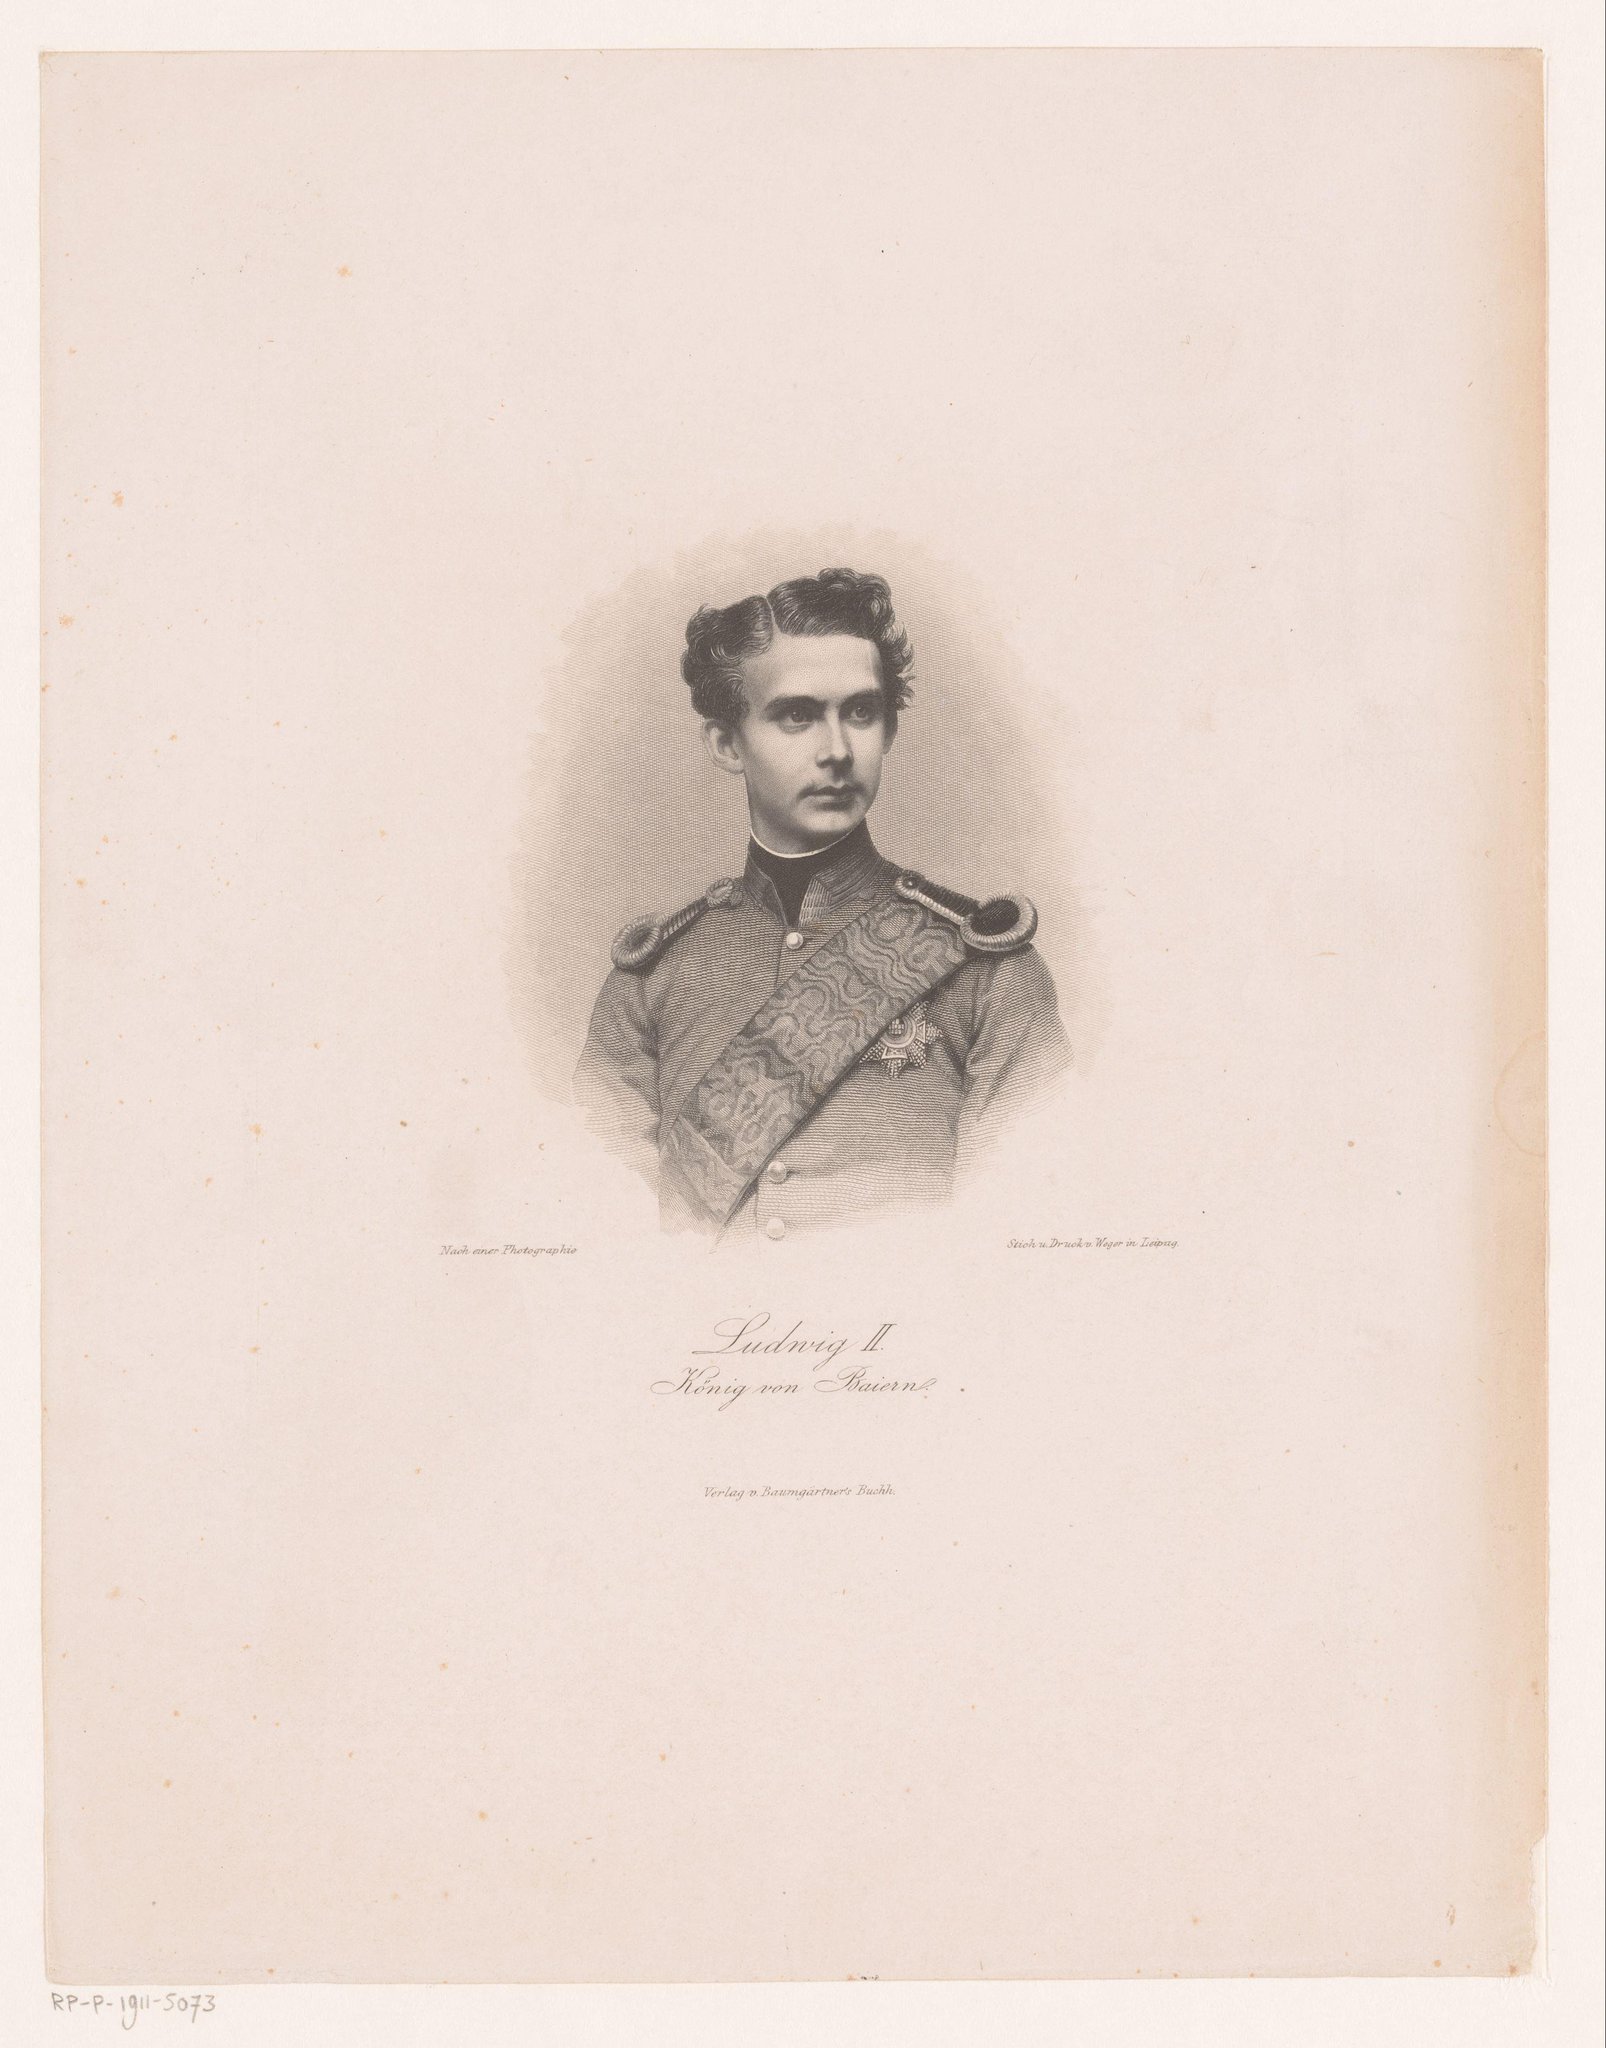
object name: print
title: Portret van Lodewijk II, koning van Beieren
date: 1864-1892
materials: paper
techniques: engraving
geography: leipzig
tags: historical persons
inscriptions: collector's mark: Lugt 2228